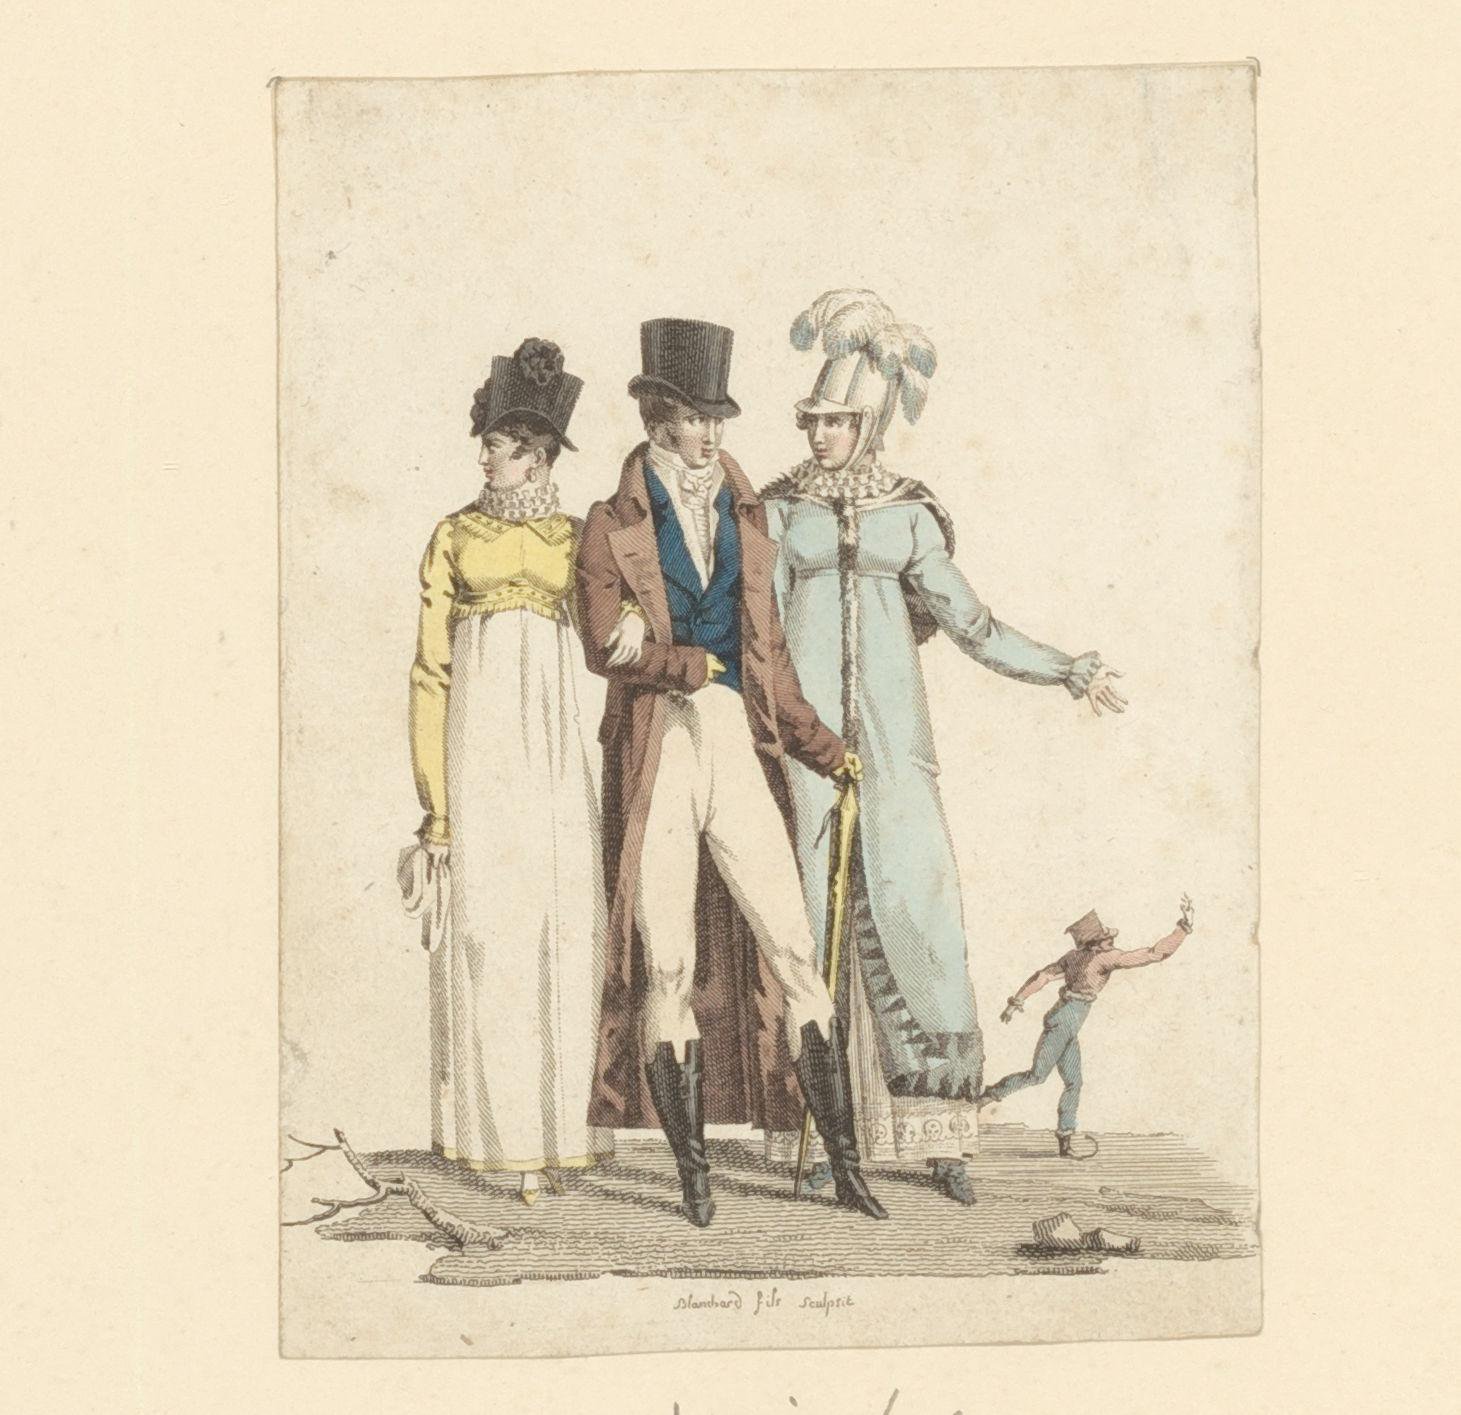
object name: print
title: Vier seizoenen mode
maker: auguste thomas marie blanchard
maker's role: print maker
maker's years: 1819-1898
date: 1830-1898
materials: paper, watercolor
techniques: engraving, etching, hand coloring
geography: france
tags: head-gear (+ women's clothes), winter ~ human activities (the four seasons of the year), fashion plates, skates (winter sports), clothes covering the entire body (+ women's clothes)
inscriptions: collector's mark: Lugt 1641, collector's mark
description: Een man wandelend met twee vrouwen, op de achtergrond een jongen schaatsend op het ijs. Onderdeel van een serie van vier prenten van de mode van ca. 1813 per seizoen. Onderwerpsrubrieken binnen de Atlas Zeden en Gewoonten: De Kleeding, Modeplaten.